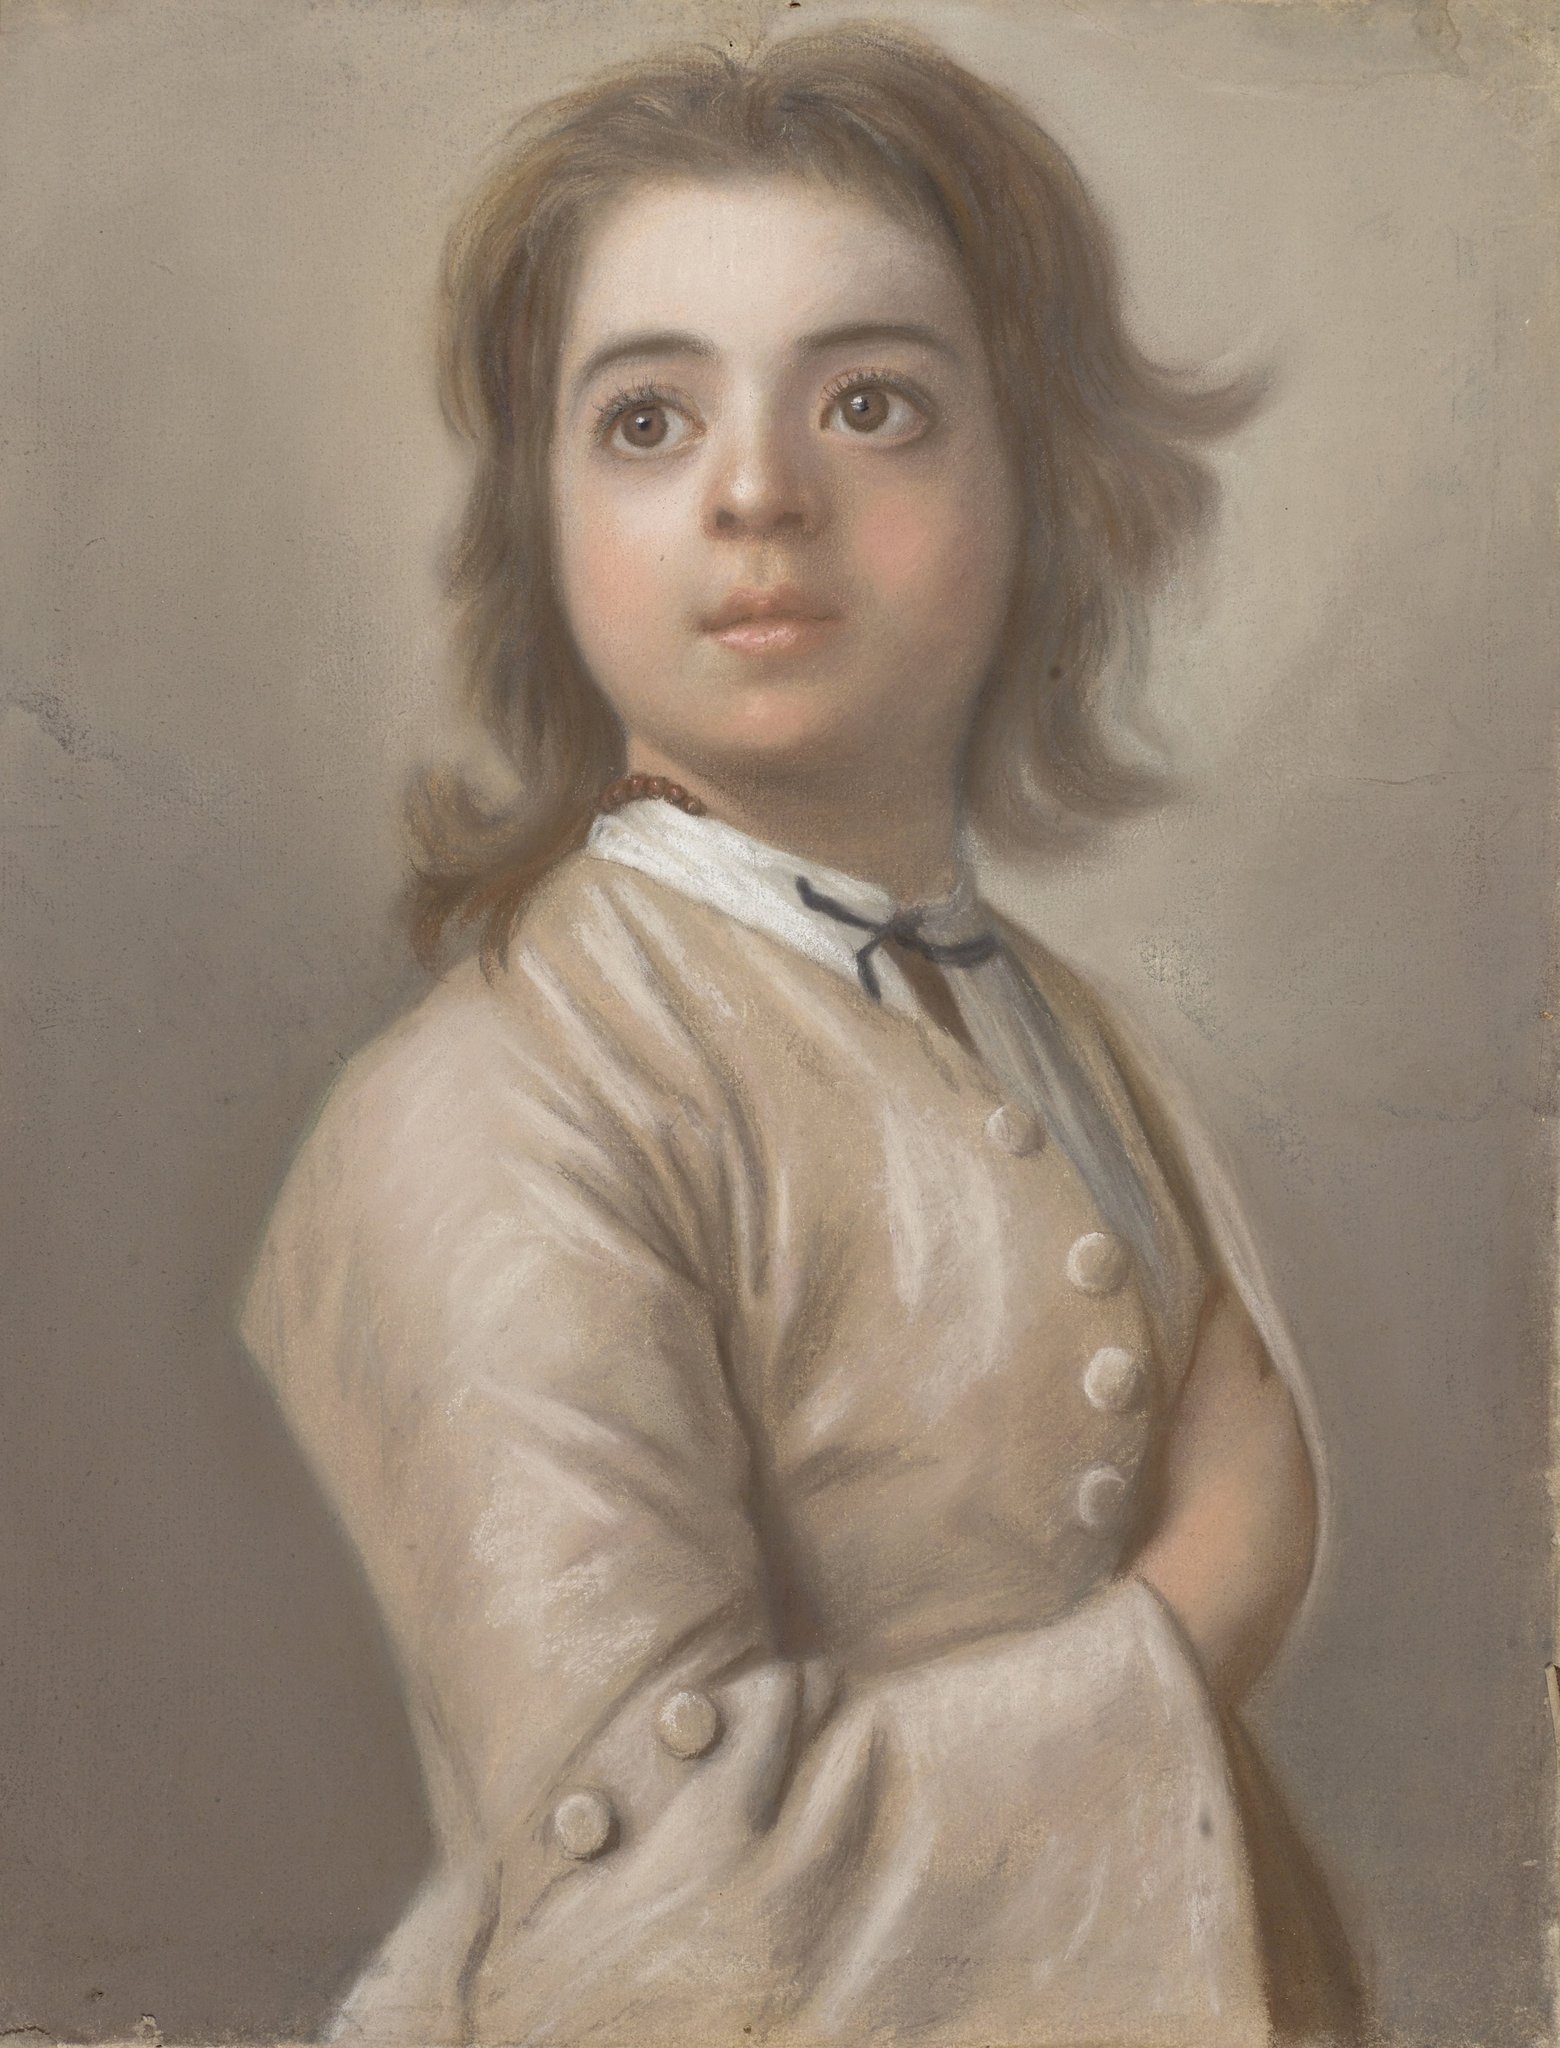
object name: pastel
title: Studie van een jongen ten halven lijve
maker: jean-etienne liotard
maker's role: painter, print maker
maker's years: 1702-1789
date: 1736-1738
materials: paper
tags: boy (child between toddler and youth), youth, adolescent, historical persons not known by name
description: Jean-Etienne Liotard (1702 - 1789). Portrait of a boy. Miss M.A. Liotard bequest, Amsterdam, 1873.